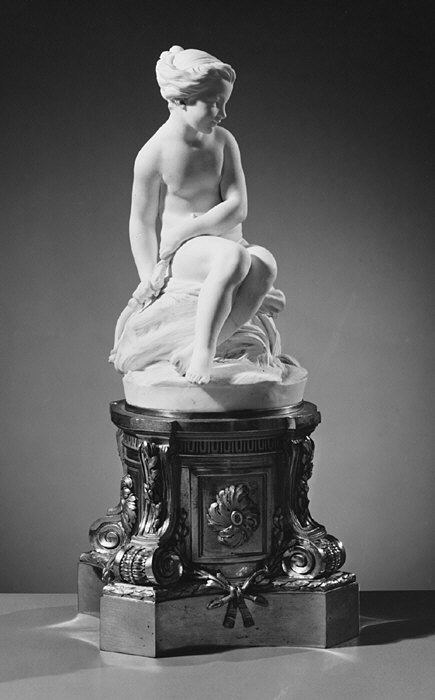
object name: figure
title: Psyche ("La Nymphe Falconet")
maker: sèvres manufactory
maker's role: manufactory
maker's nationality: french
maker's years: 1740-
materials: biscuit, gilt bronze, paste, porcelain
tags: psyche,flowers